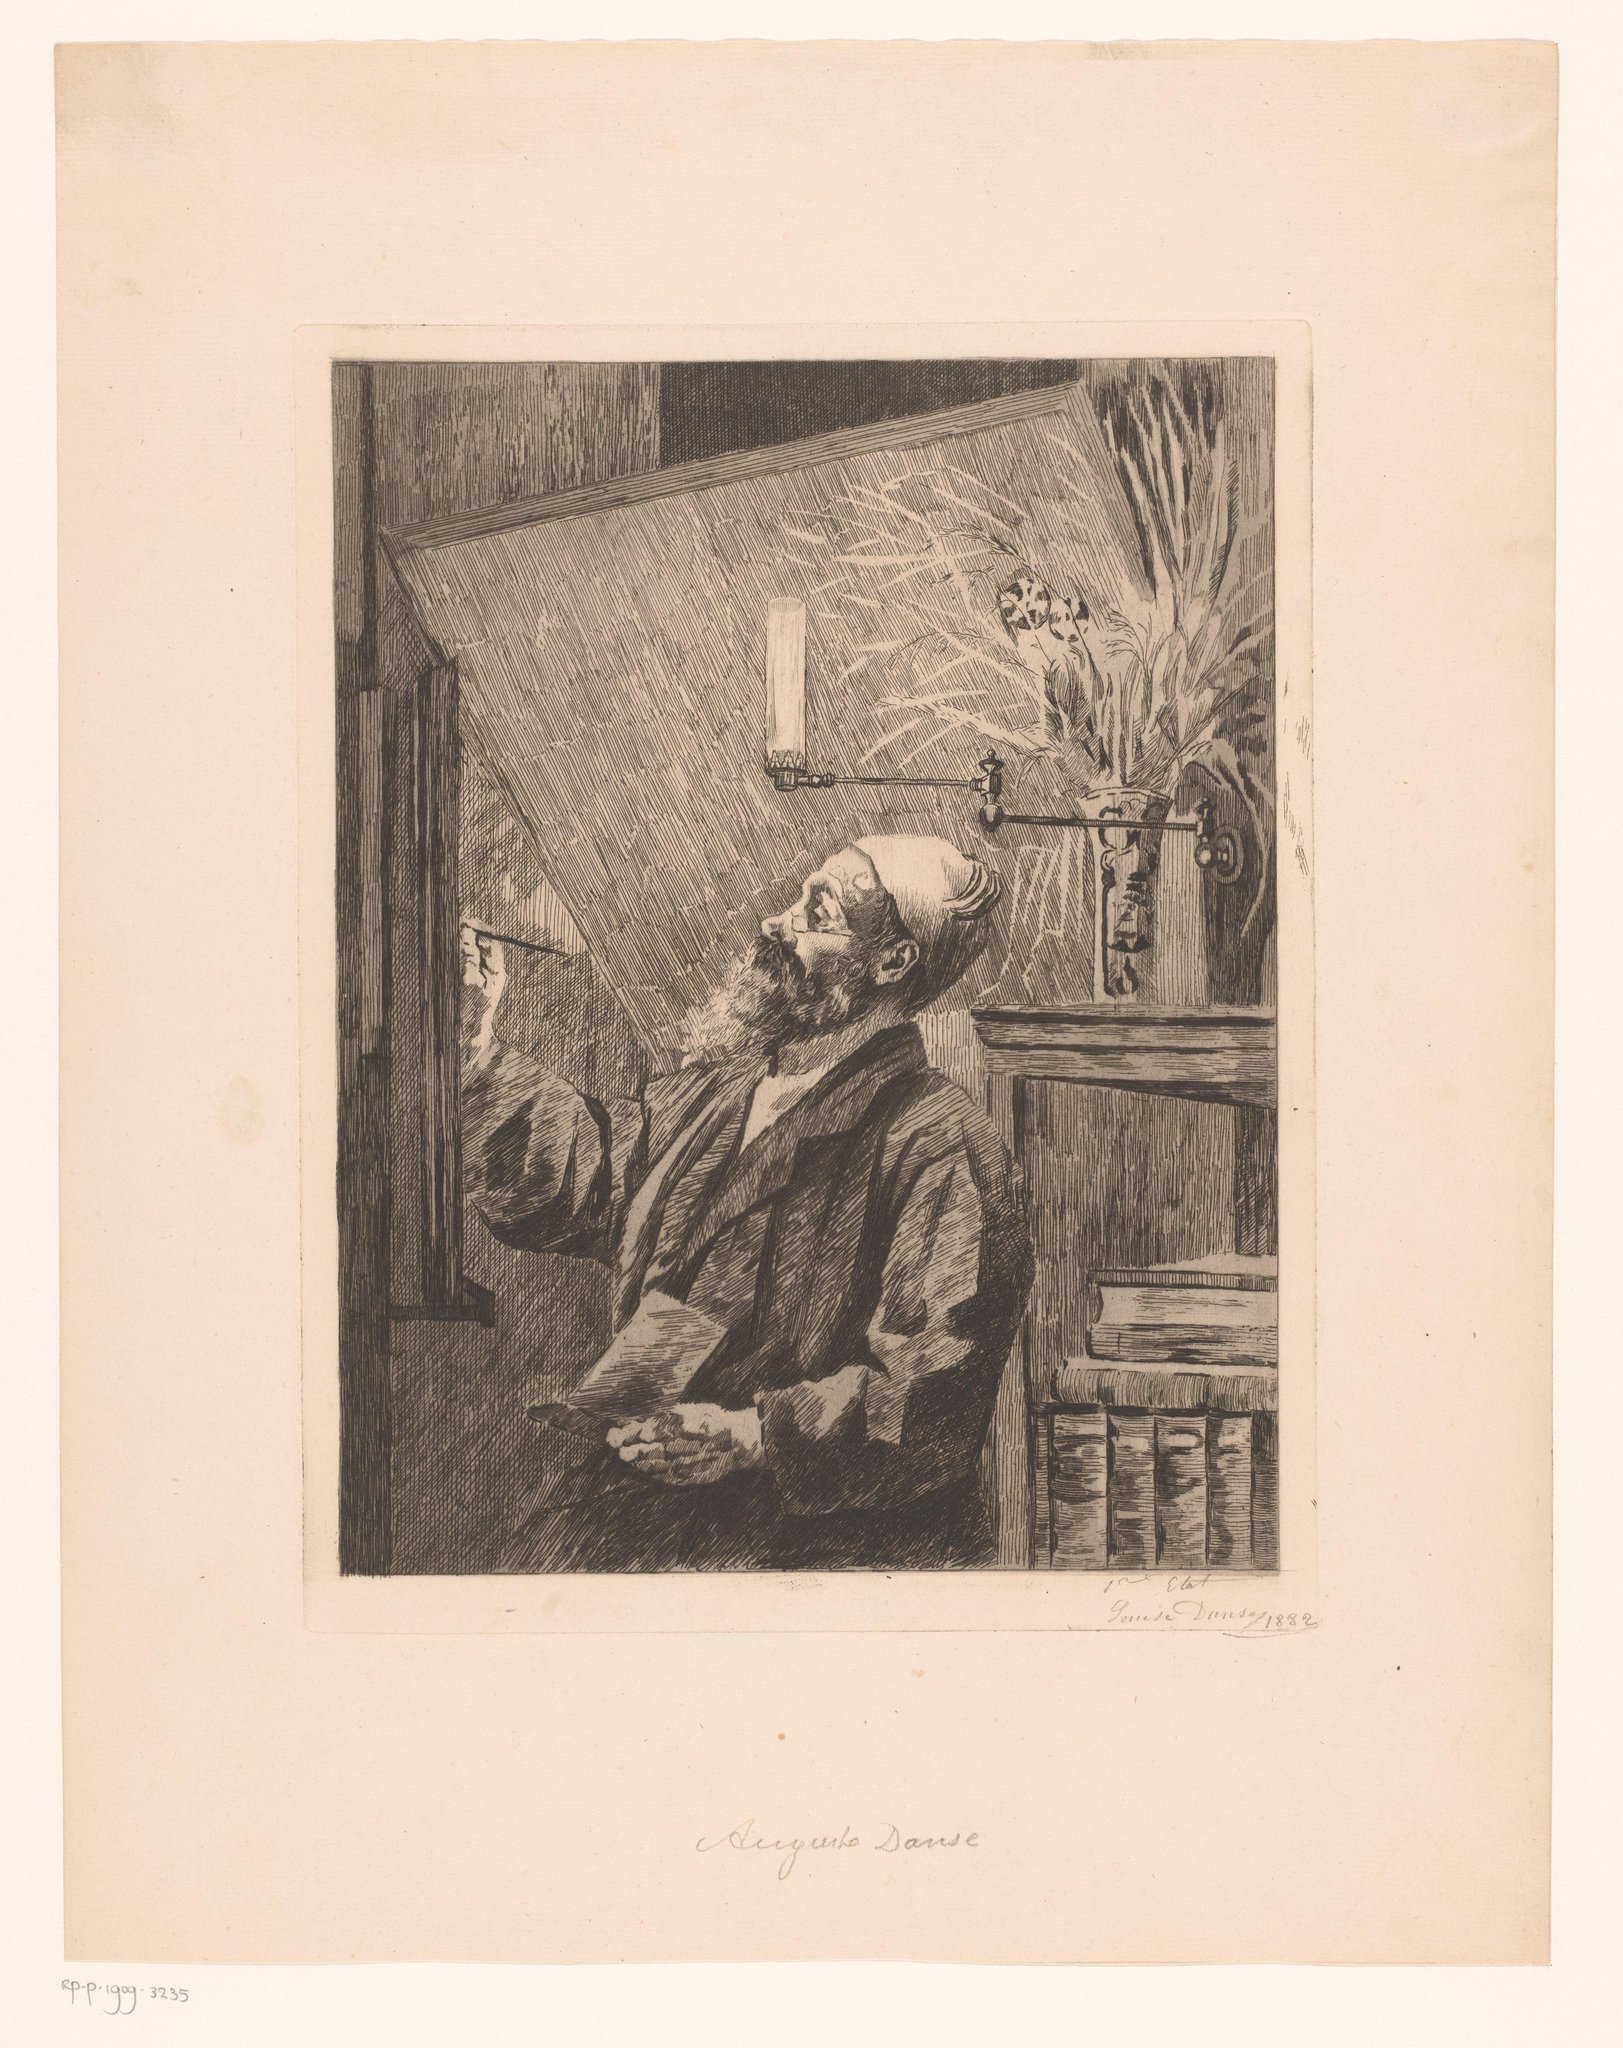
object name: print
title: Auguste Danse aan de schildersezel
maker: louise danse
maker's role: painter, print maker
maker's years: 1867-1948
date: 1882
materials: paper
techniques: drypoint, etching, intaglio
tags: brussels, print maker, auguste danse, painter at work, in his studio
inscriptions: collector's mark: Lugt 2228, annotation: ‘1re Etat’